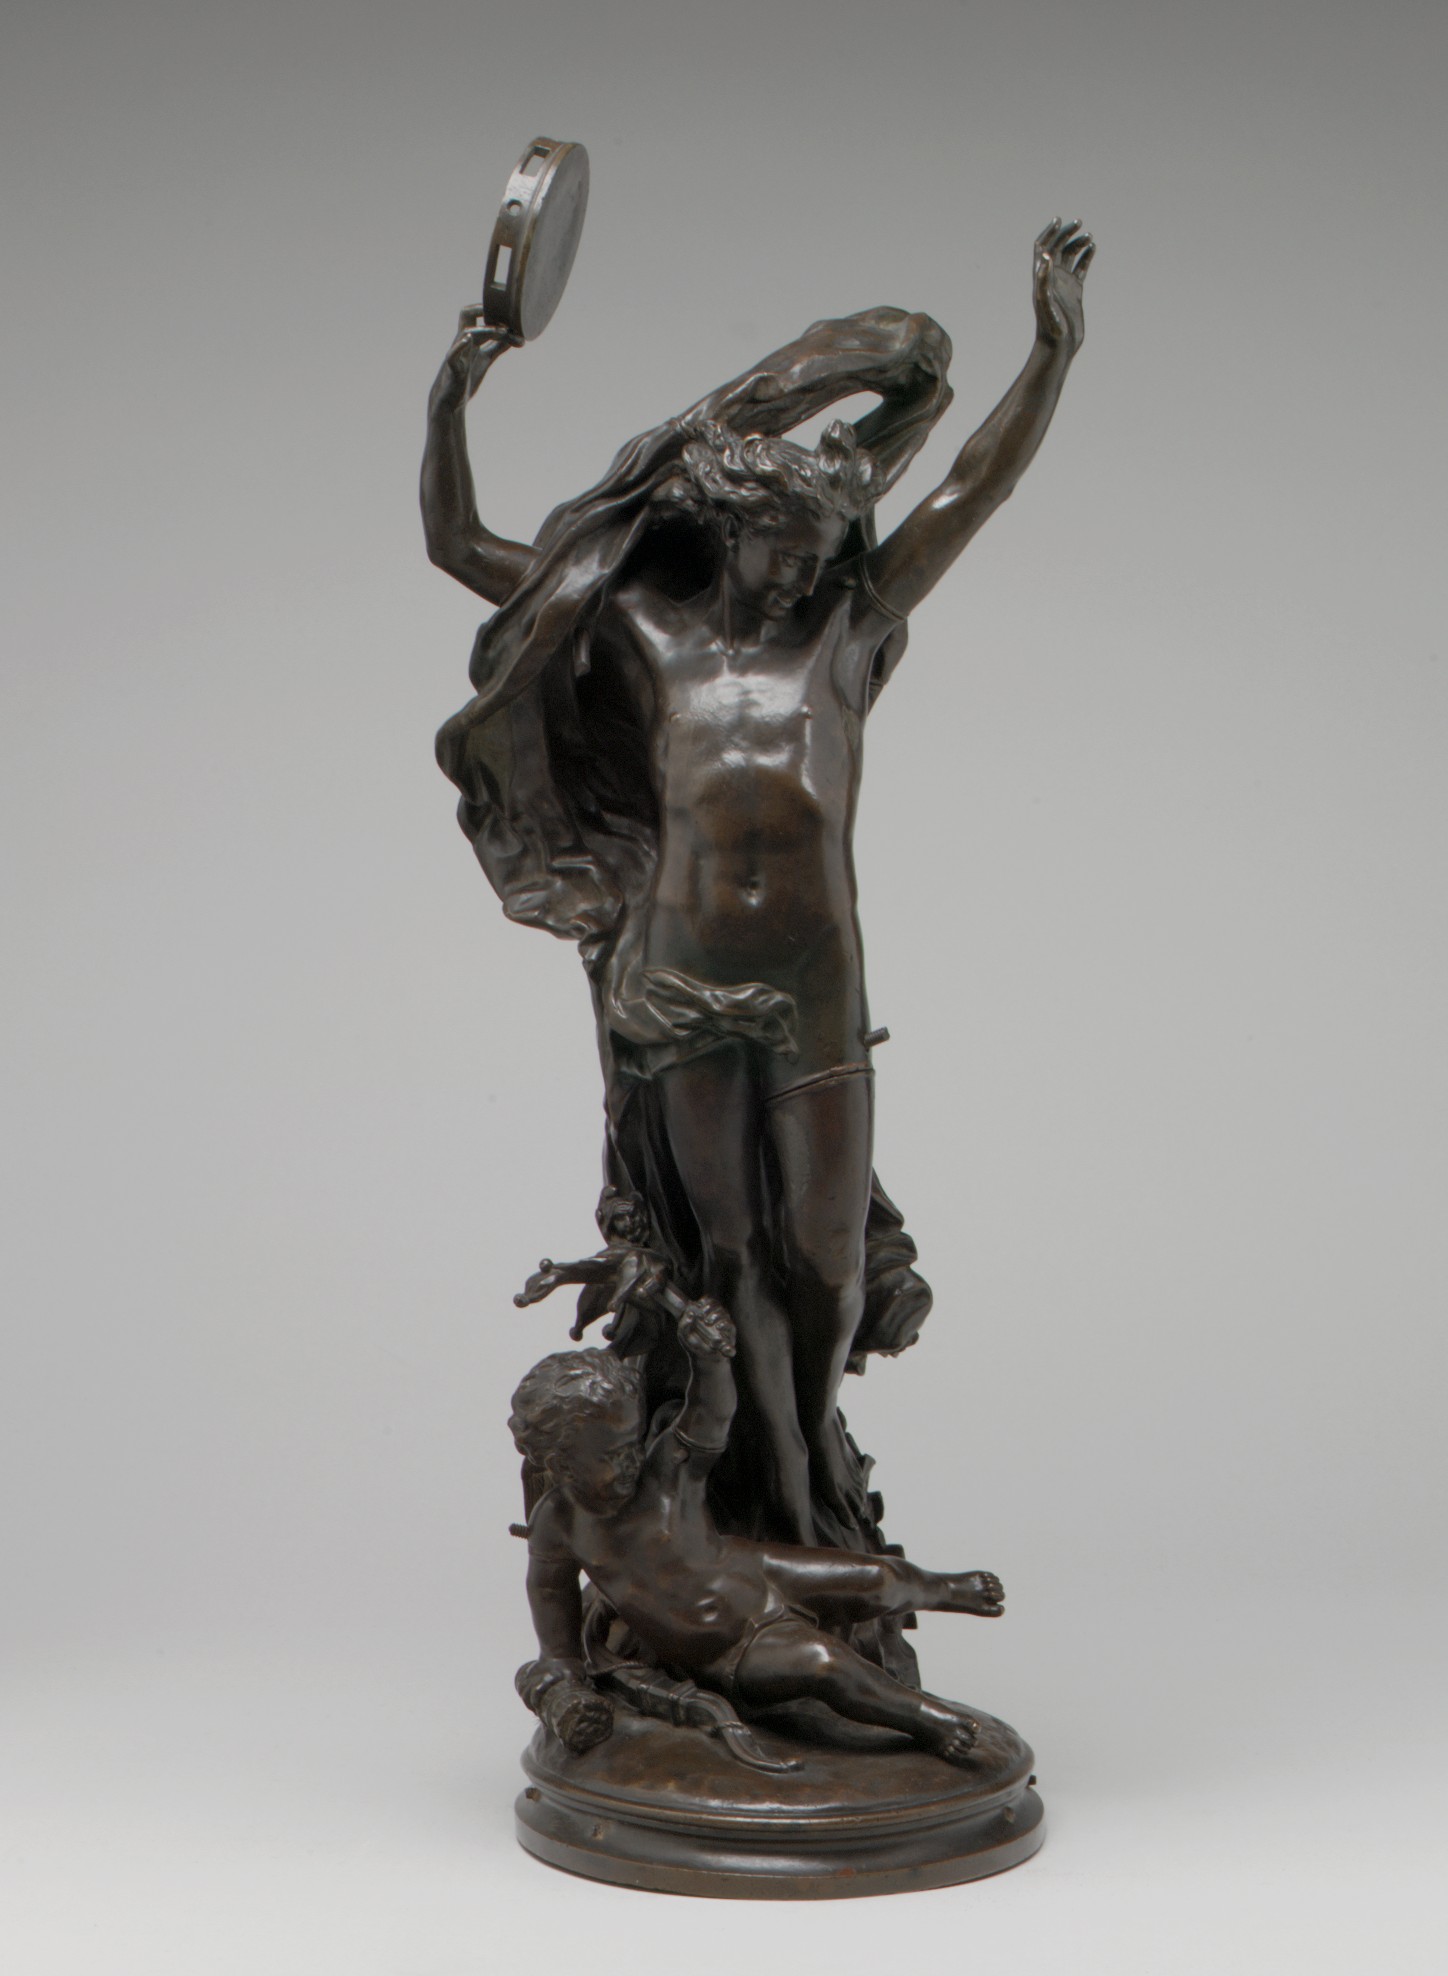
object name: statuette group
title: Genius of the Dance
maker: jean-baptiste carpeaux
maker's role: artist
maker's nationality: french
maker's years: 1827-1875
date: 1864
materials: bronze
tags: musical instruments,dance,children